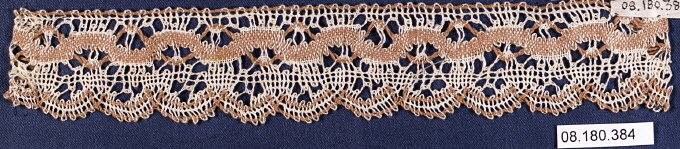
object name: piece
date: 1801-1900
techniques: lace